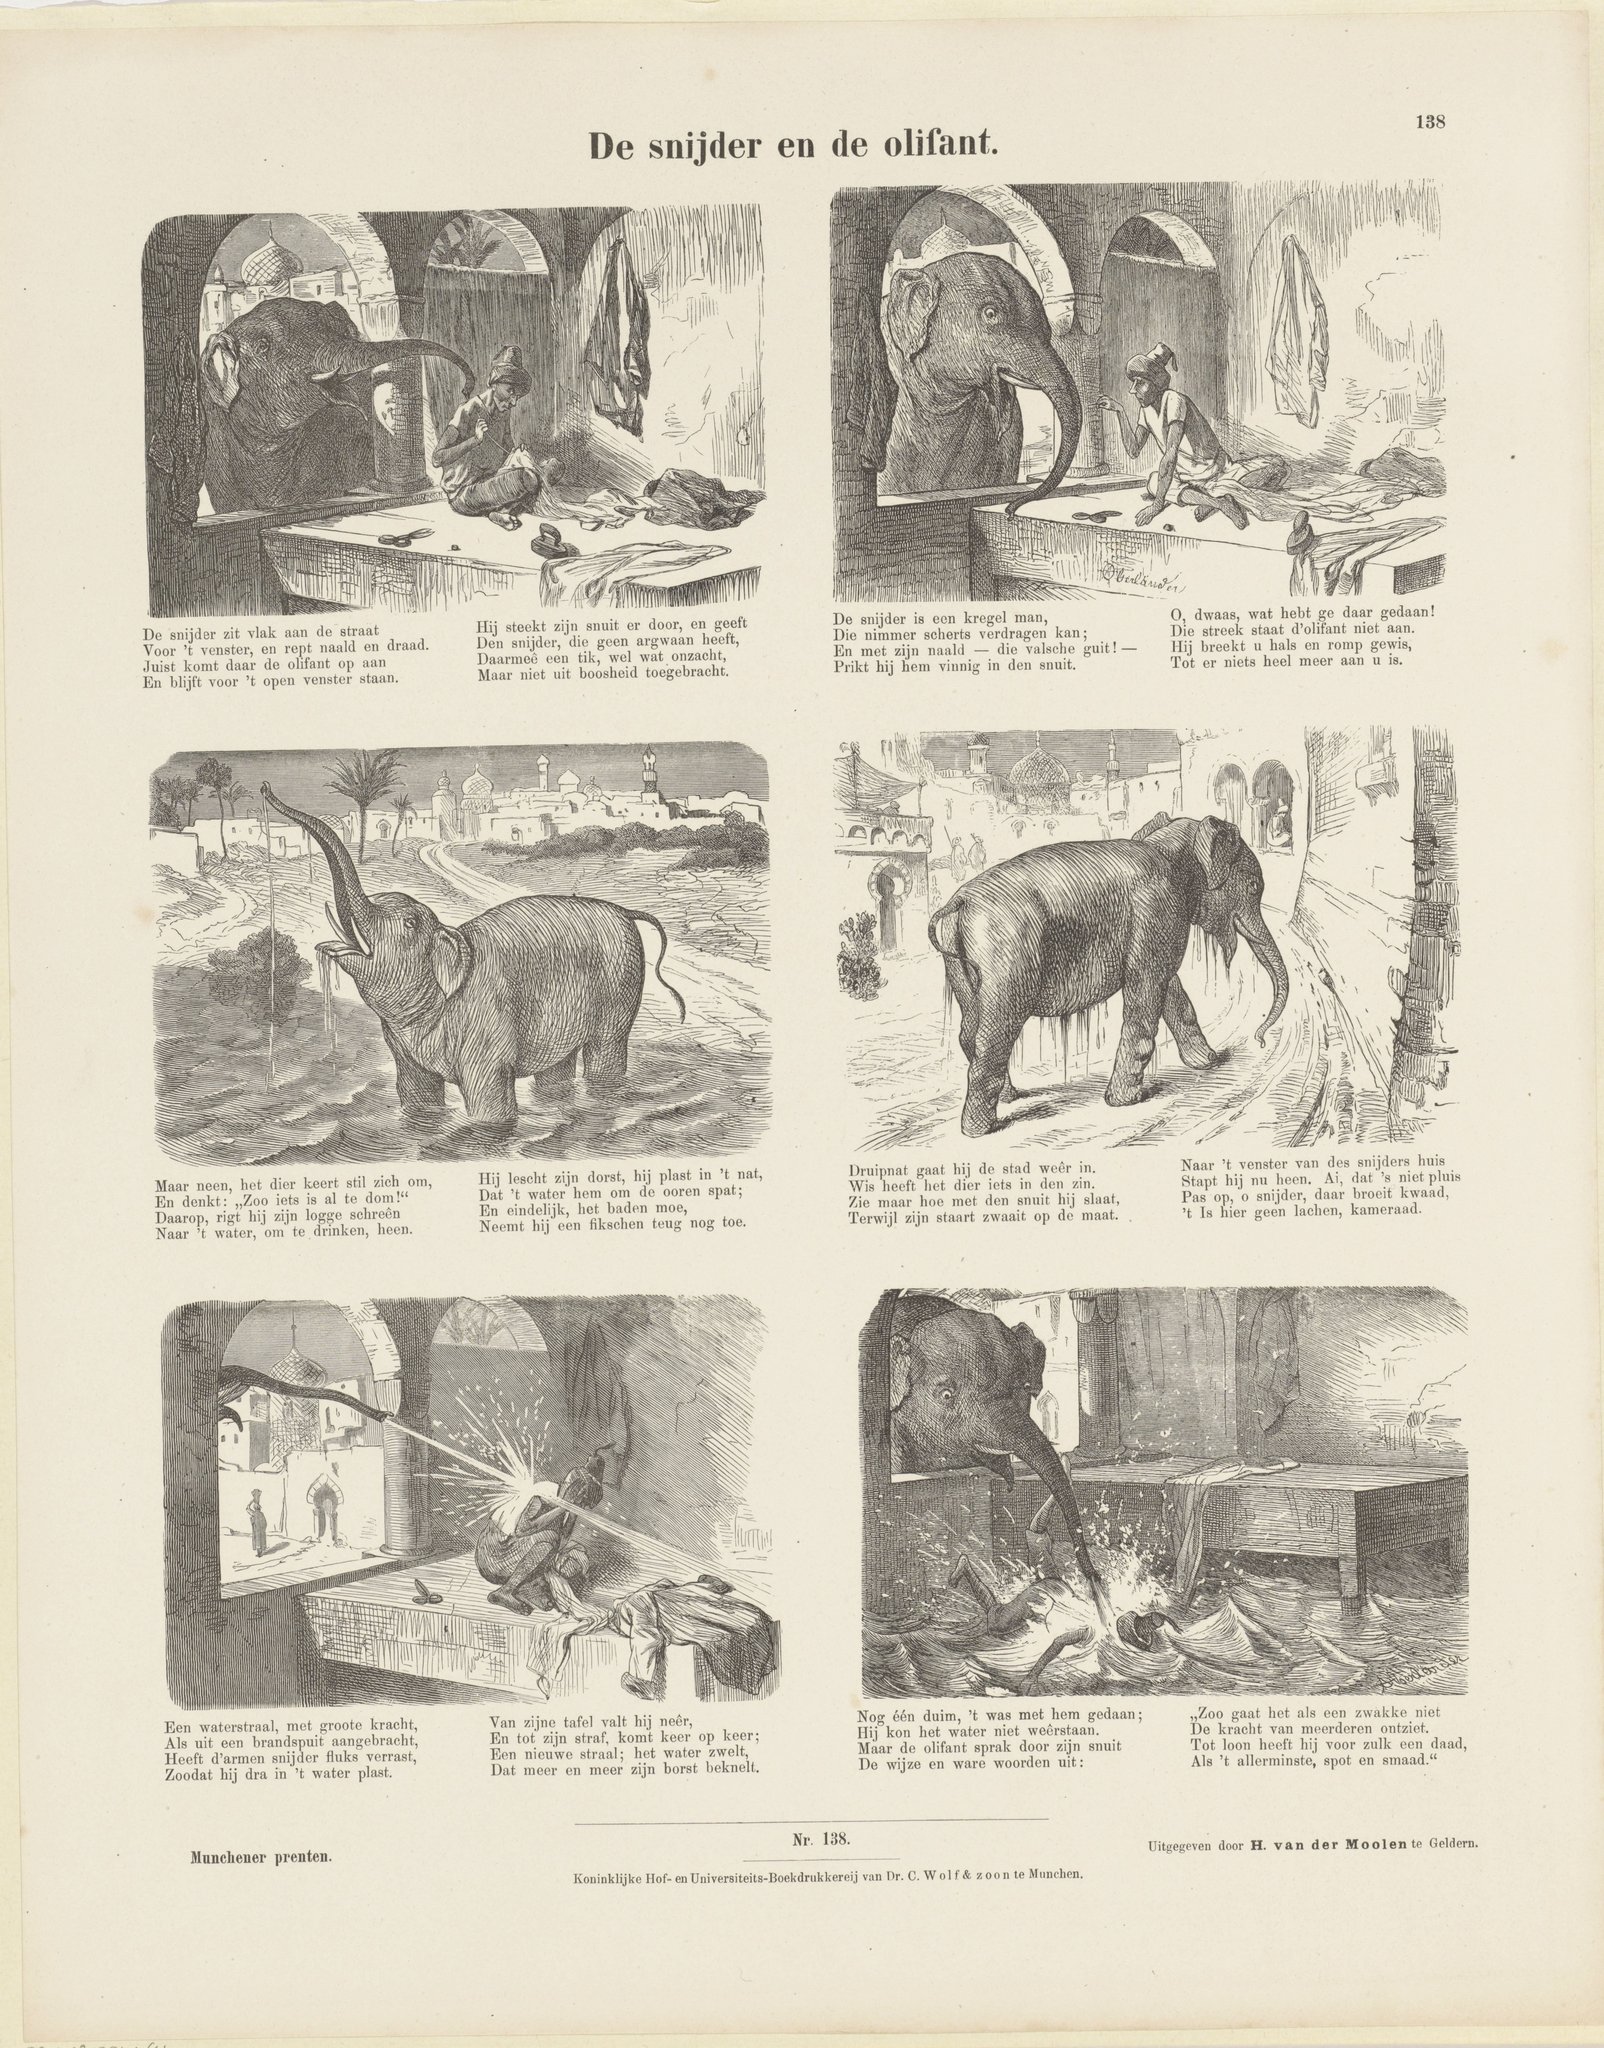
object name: popular print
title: Munchener platen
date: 1843-1920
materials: paper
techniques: letterpress printing, engraving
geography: geldern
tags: tailor, dressmaker, trunked animals: elephant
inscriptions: collector's mark: Lugt 2760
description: Blad met 6 voorstellingen over een olifant die wraak neemt op een kleermaker die in zijn snuit prikte met een naald. Onder elke voorstelling een achtregelig vers in twee kolommen. Genummerd midden onder: Nro. 138. Genummerd rechtsboven: 138.